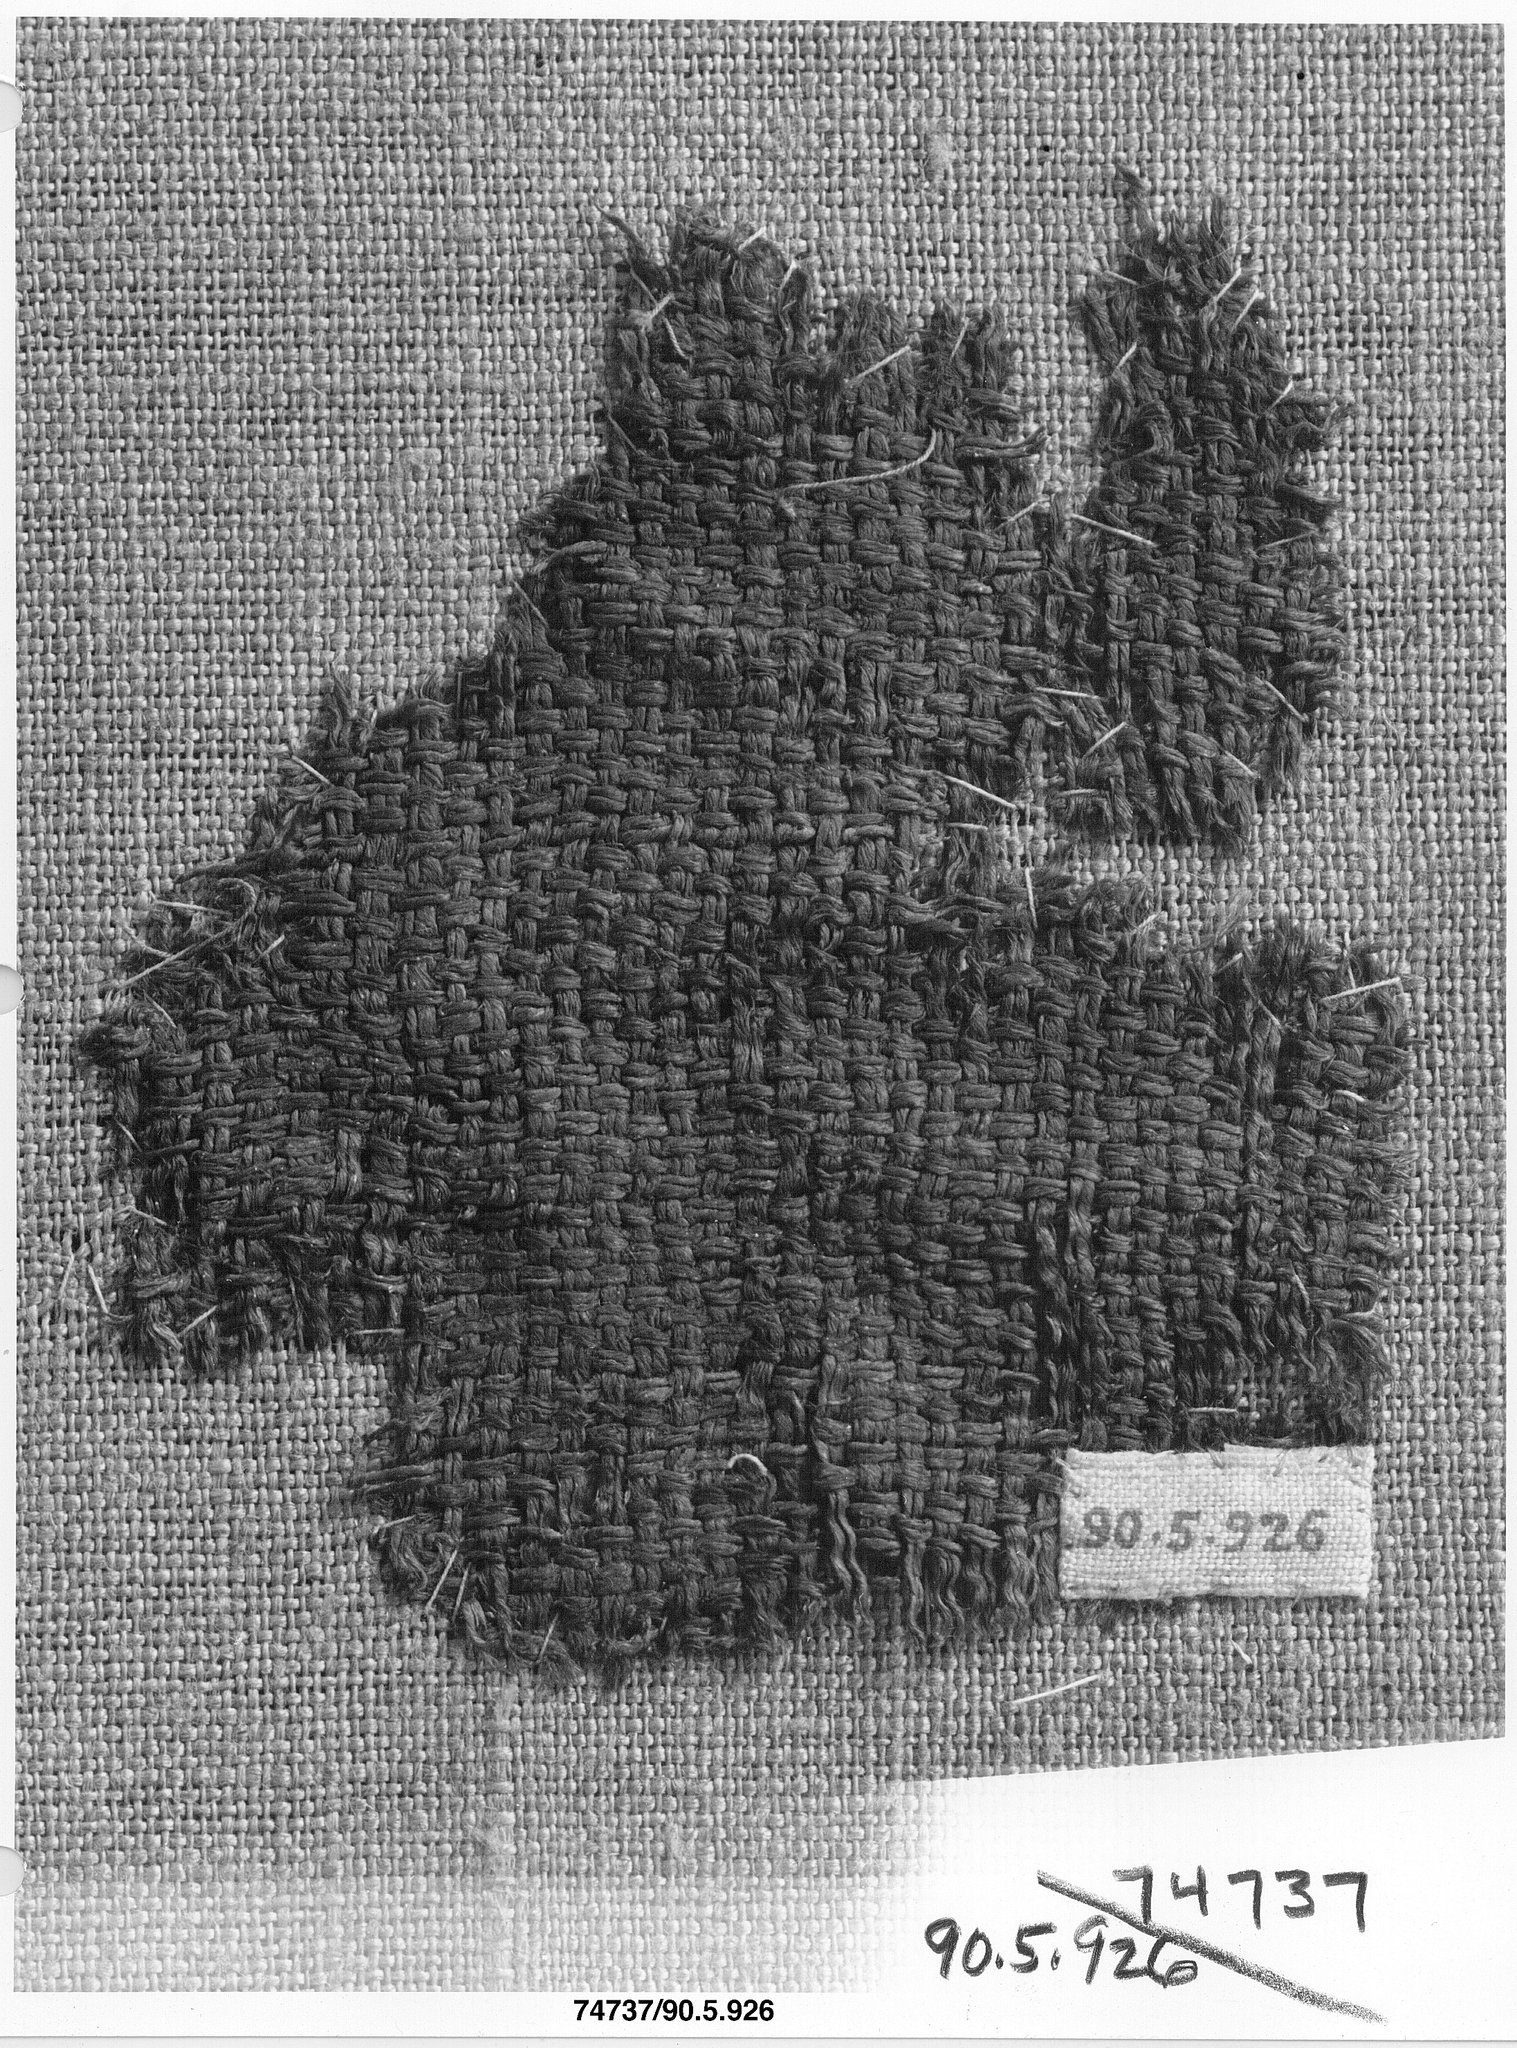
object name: textile fragment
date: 401-600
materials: linen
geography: egypt